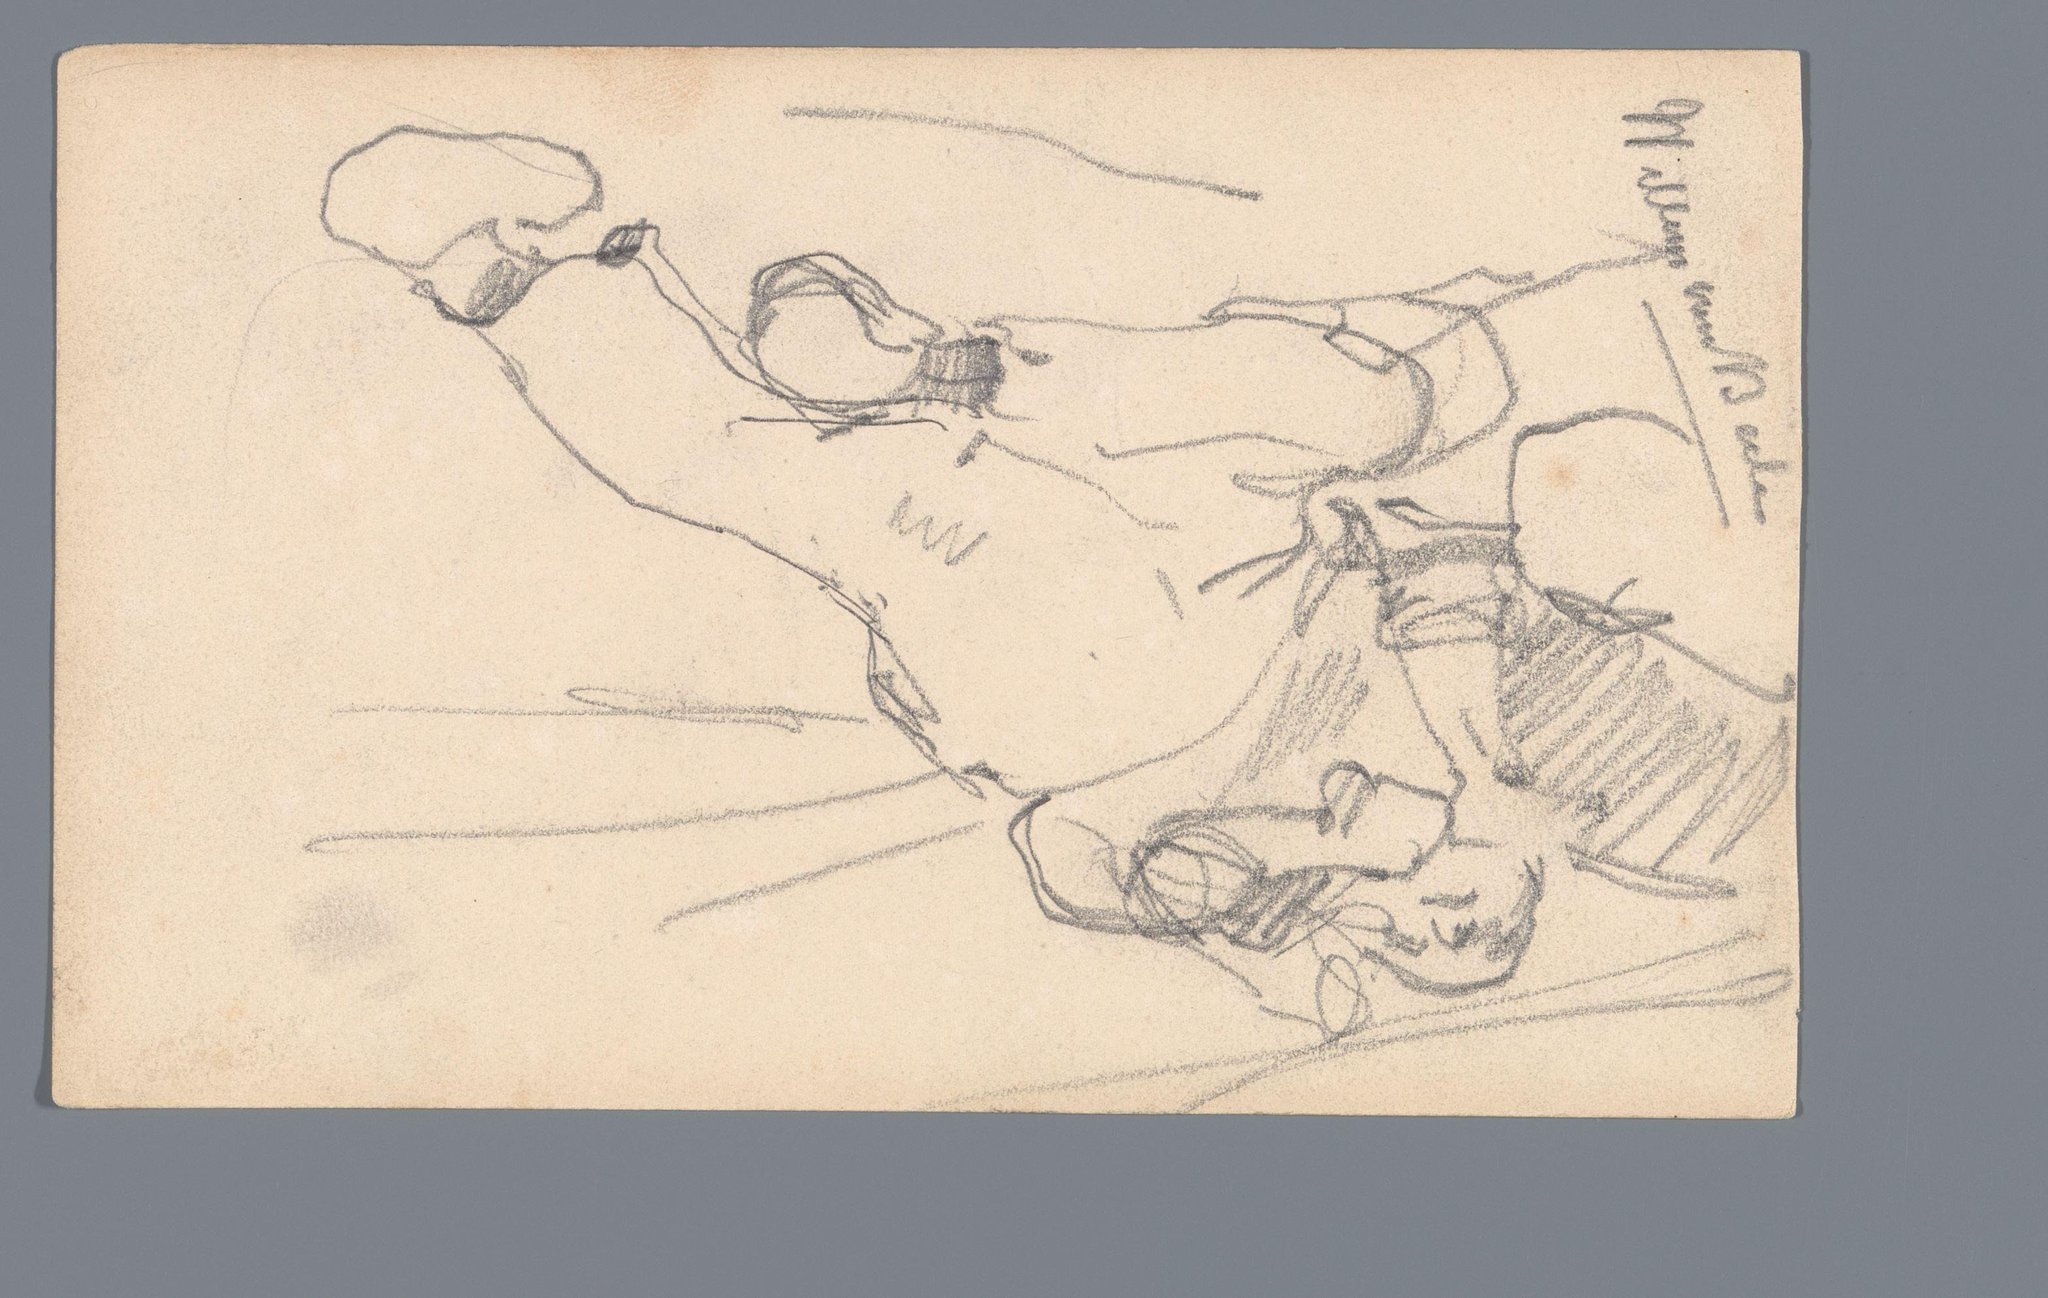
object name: drawing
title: Liggende man, mogelijk Willem van Beelen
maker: george hendrik breitner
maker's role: draughtsman, painter, print maker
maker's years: 1857-1923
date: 1880-1882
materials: paper, pencil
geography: rotterdam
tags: adult man (+ lying)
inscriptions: annotation: ‘Willem van Beelen’